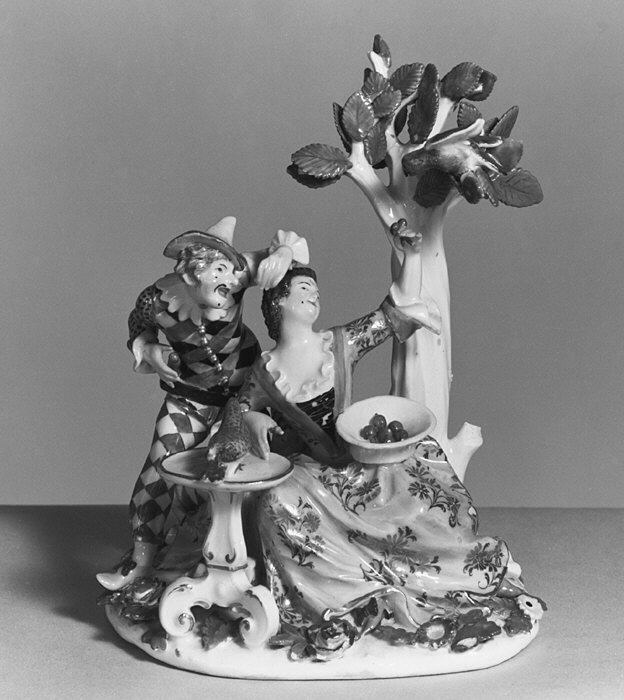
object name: group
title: Harlequin and Columbine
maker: meissen manufactory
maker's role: manufactory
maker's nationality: german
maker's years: 1710-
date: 1745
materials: hard paste porcelain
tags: men,lovers,women,leaves